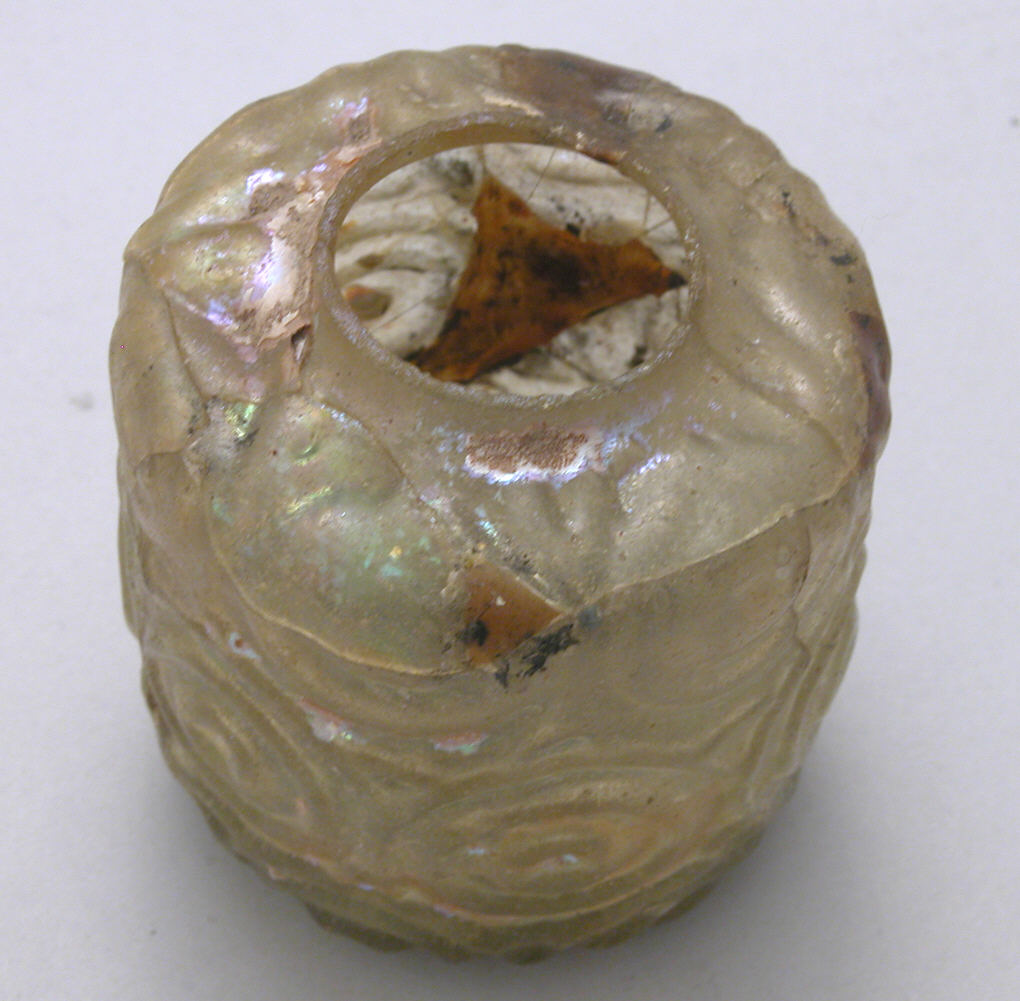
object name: bottle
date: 1001-1200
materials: glass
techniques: glassblowing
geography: iran